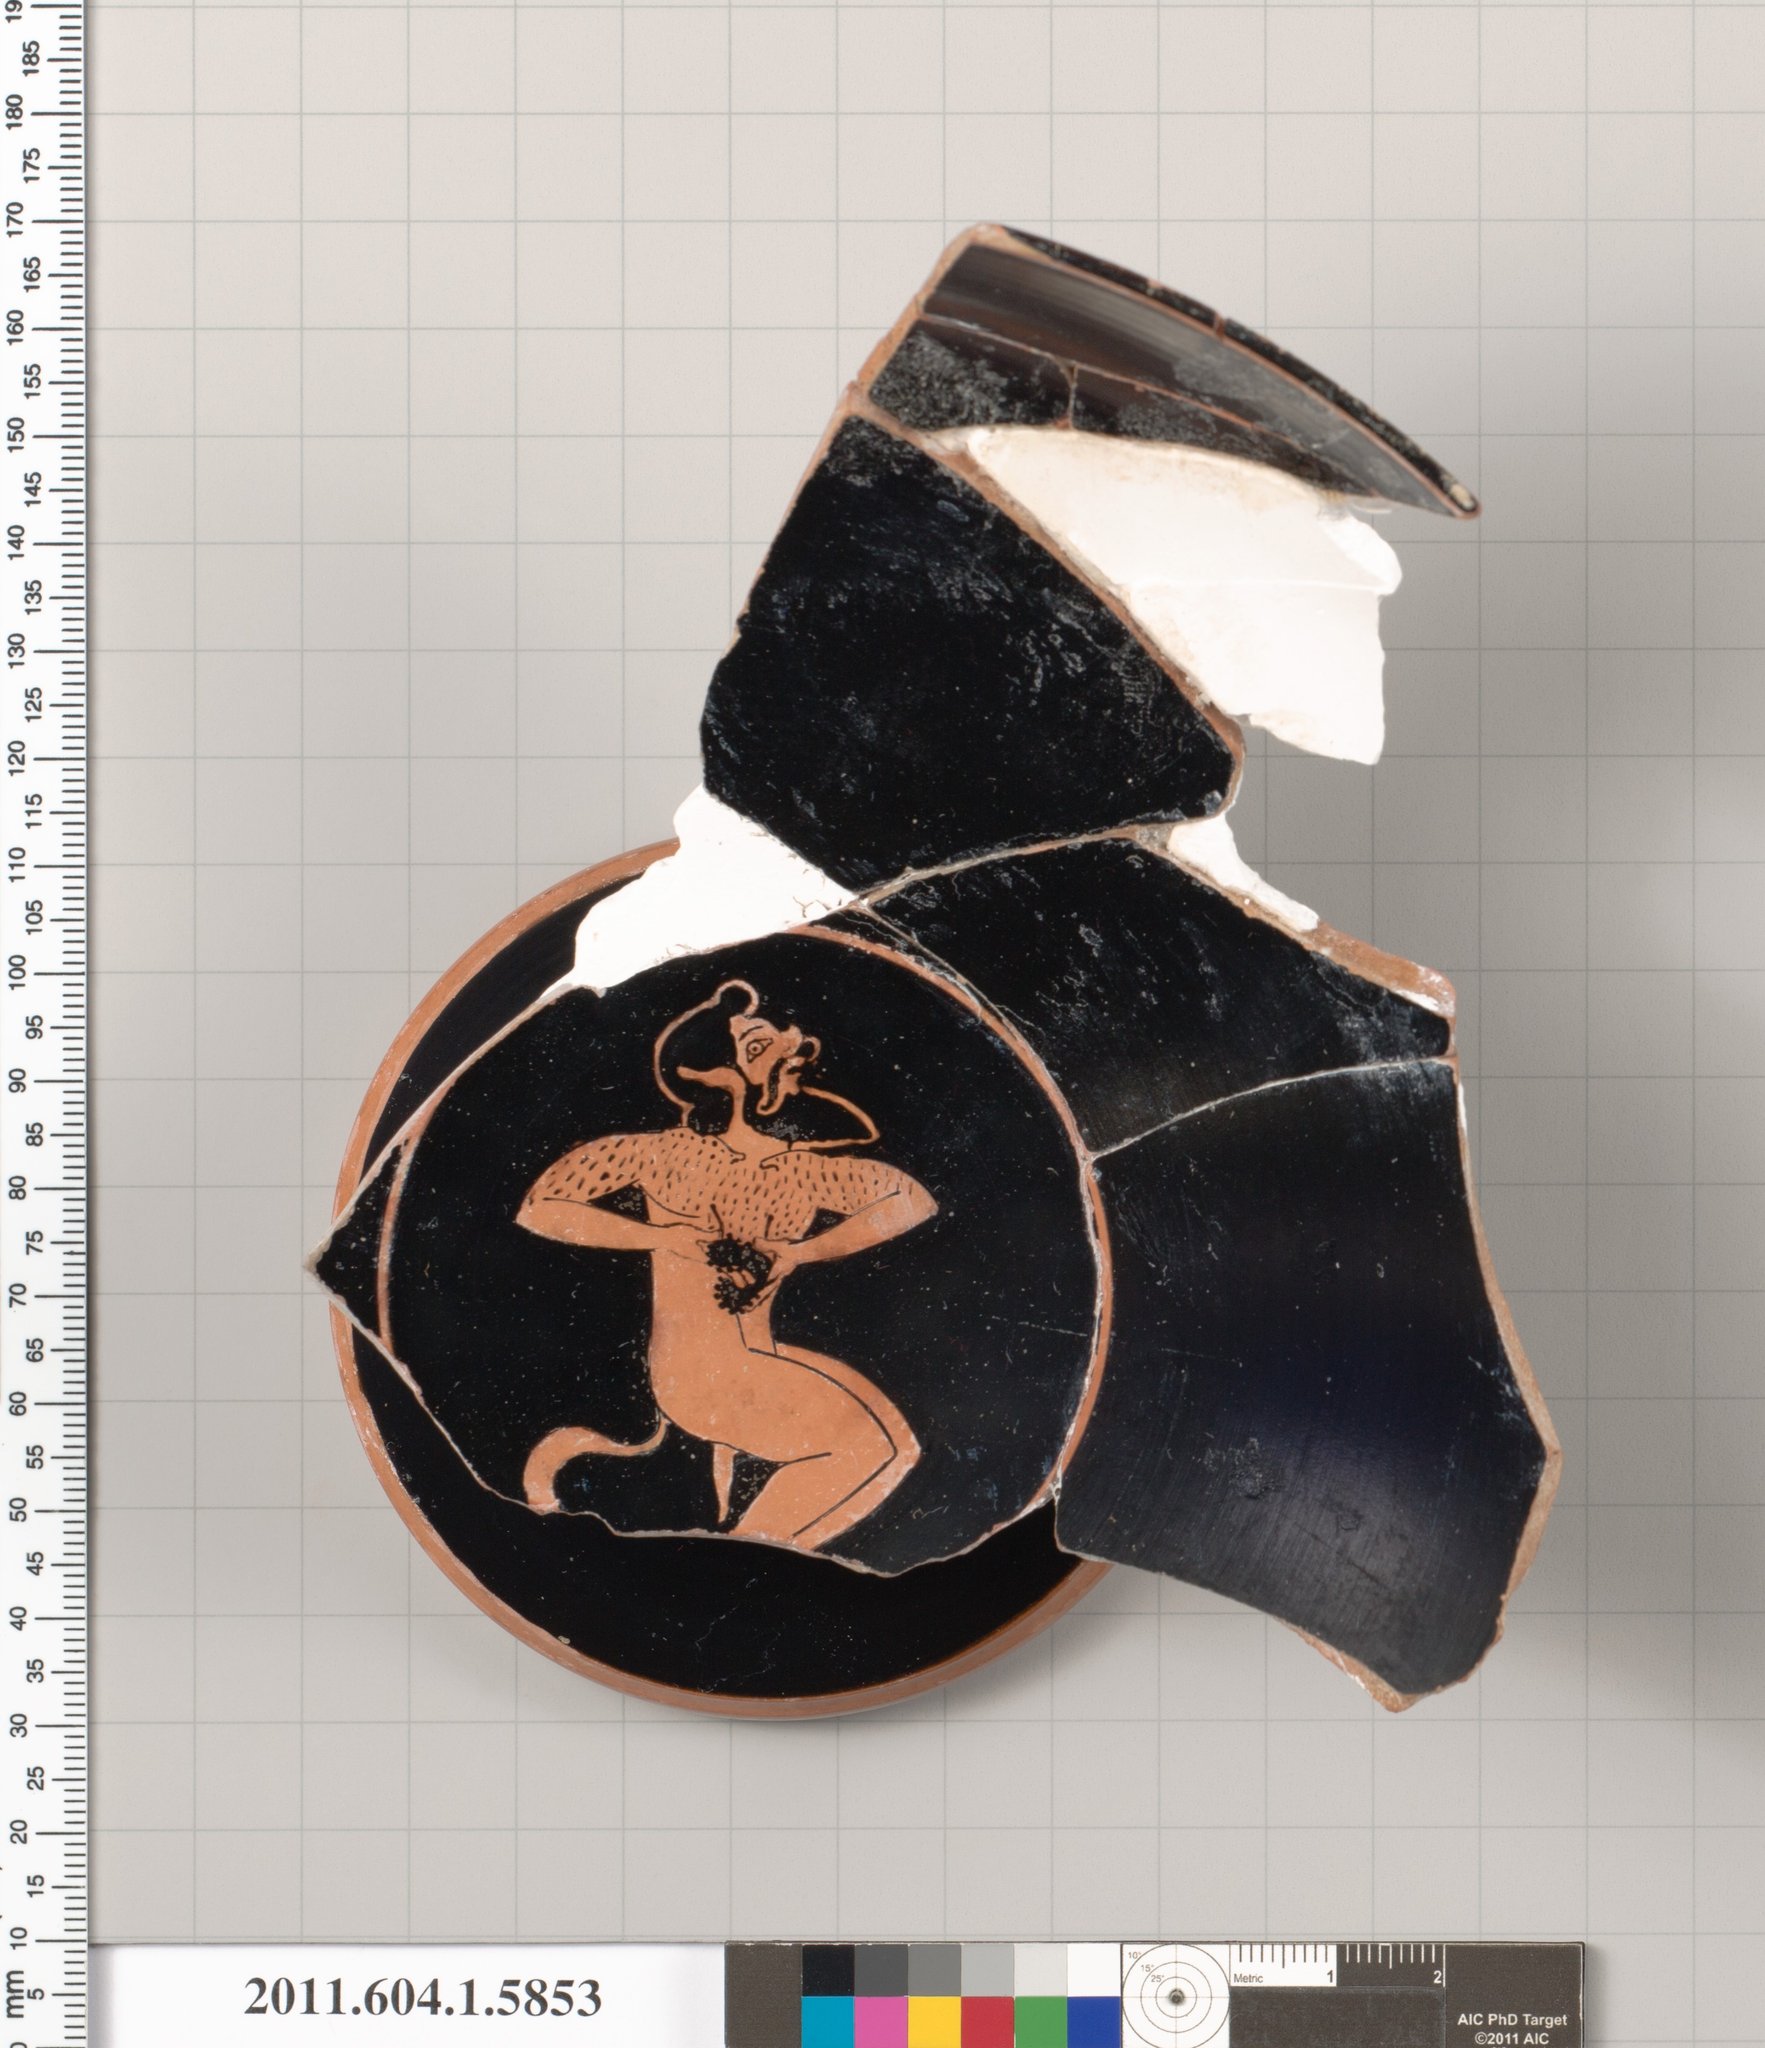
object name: kylix fragment, eye cup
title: Terracotta fragment of a kylix: eye-cup (drinking cup)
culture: greek, attic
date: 520-510 BCE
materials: terracotta